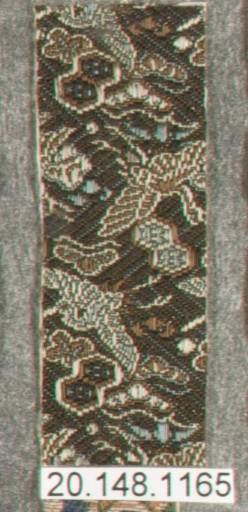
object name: piece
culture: japanese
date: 1801-1900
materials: silk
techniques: compound weave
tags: birds